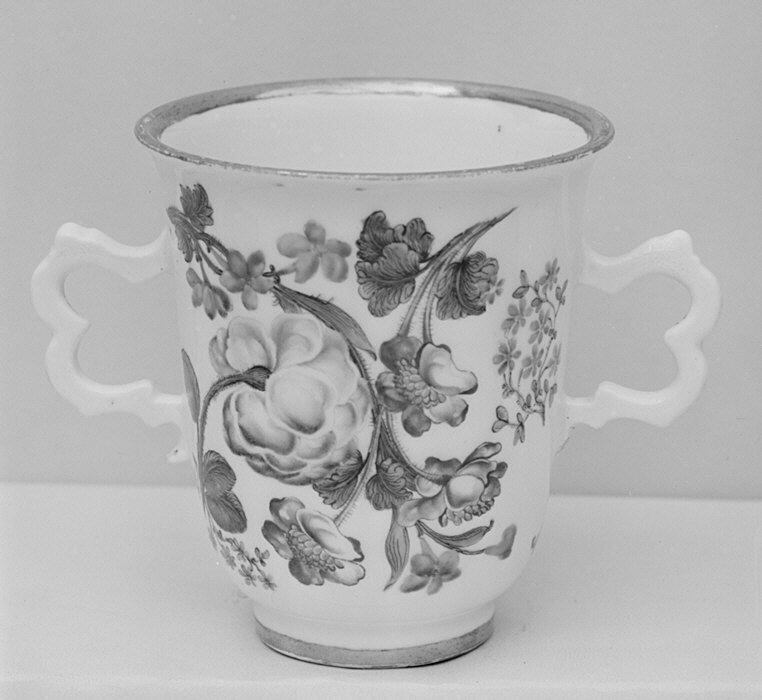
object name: cup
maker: vienna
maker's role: manufactory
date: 1730-1740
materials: hard paste porcelain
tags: flowers